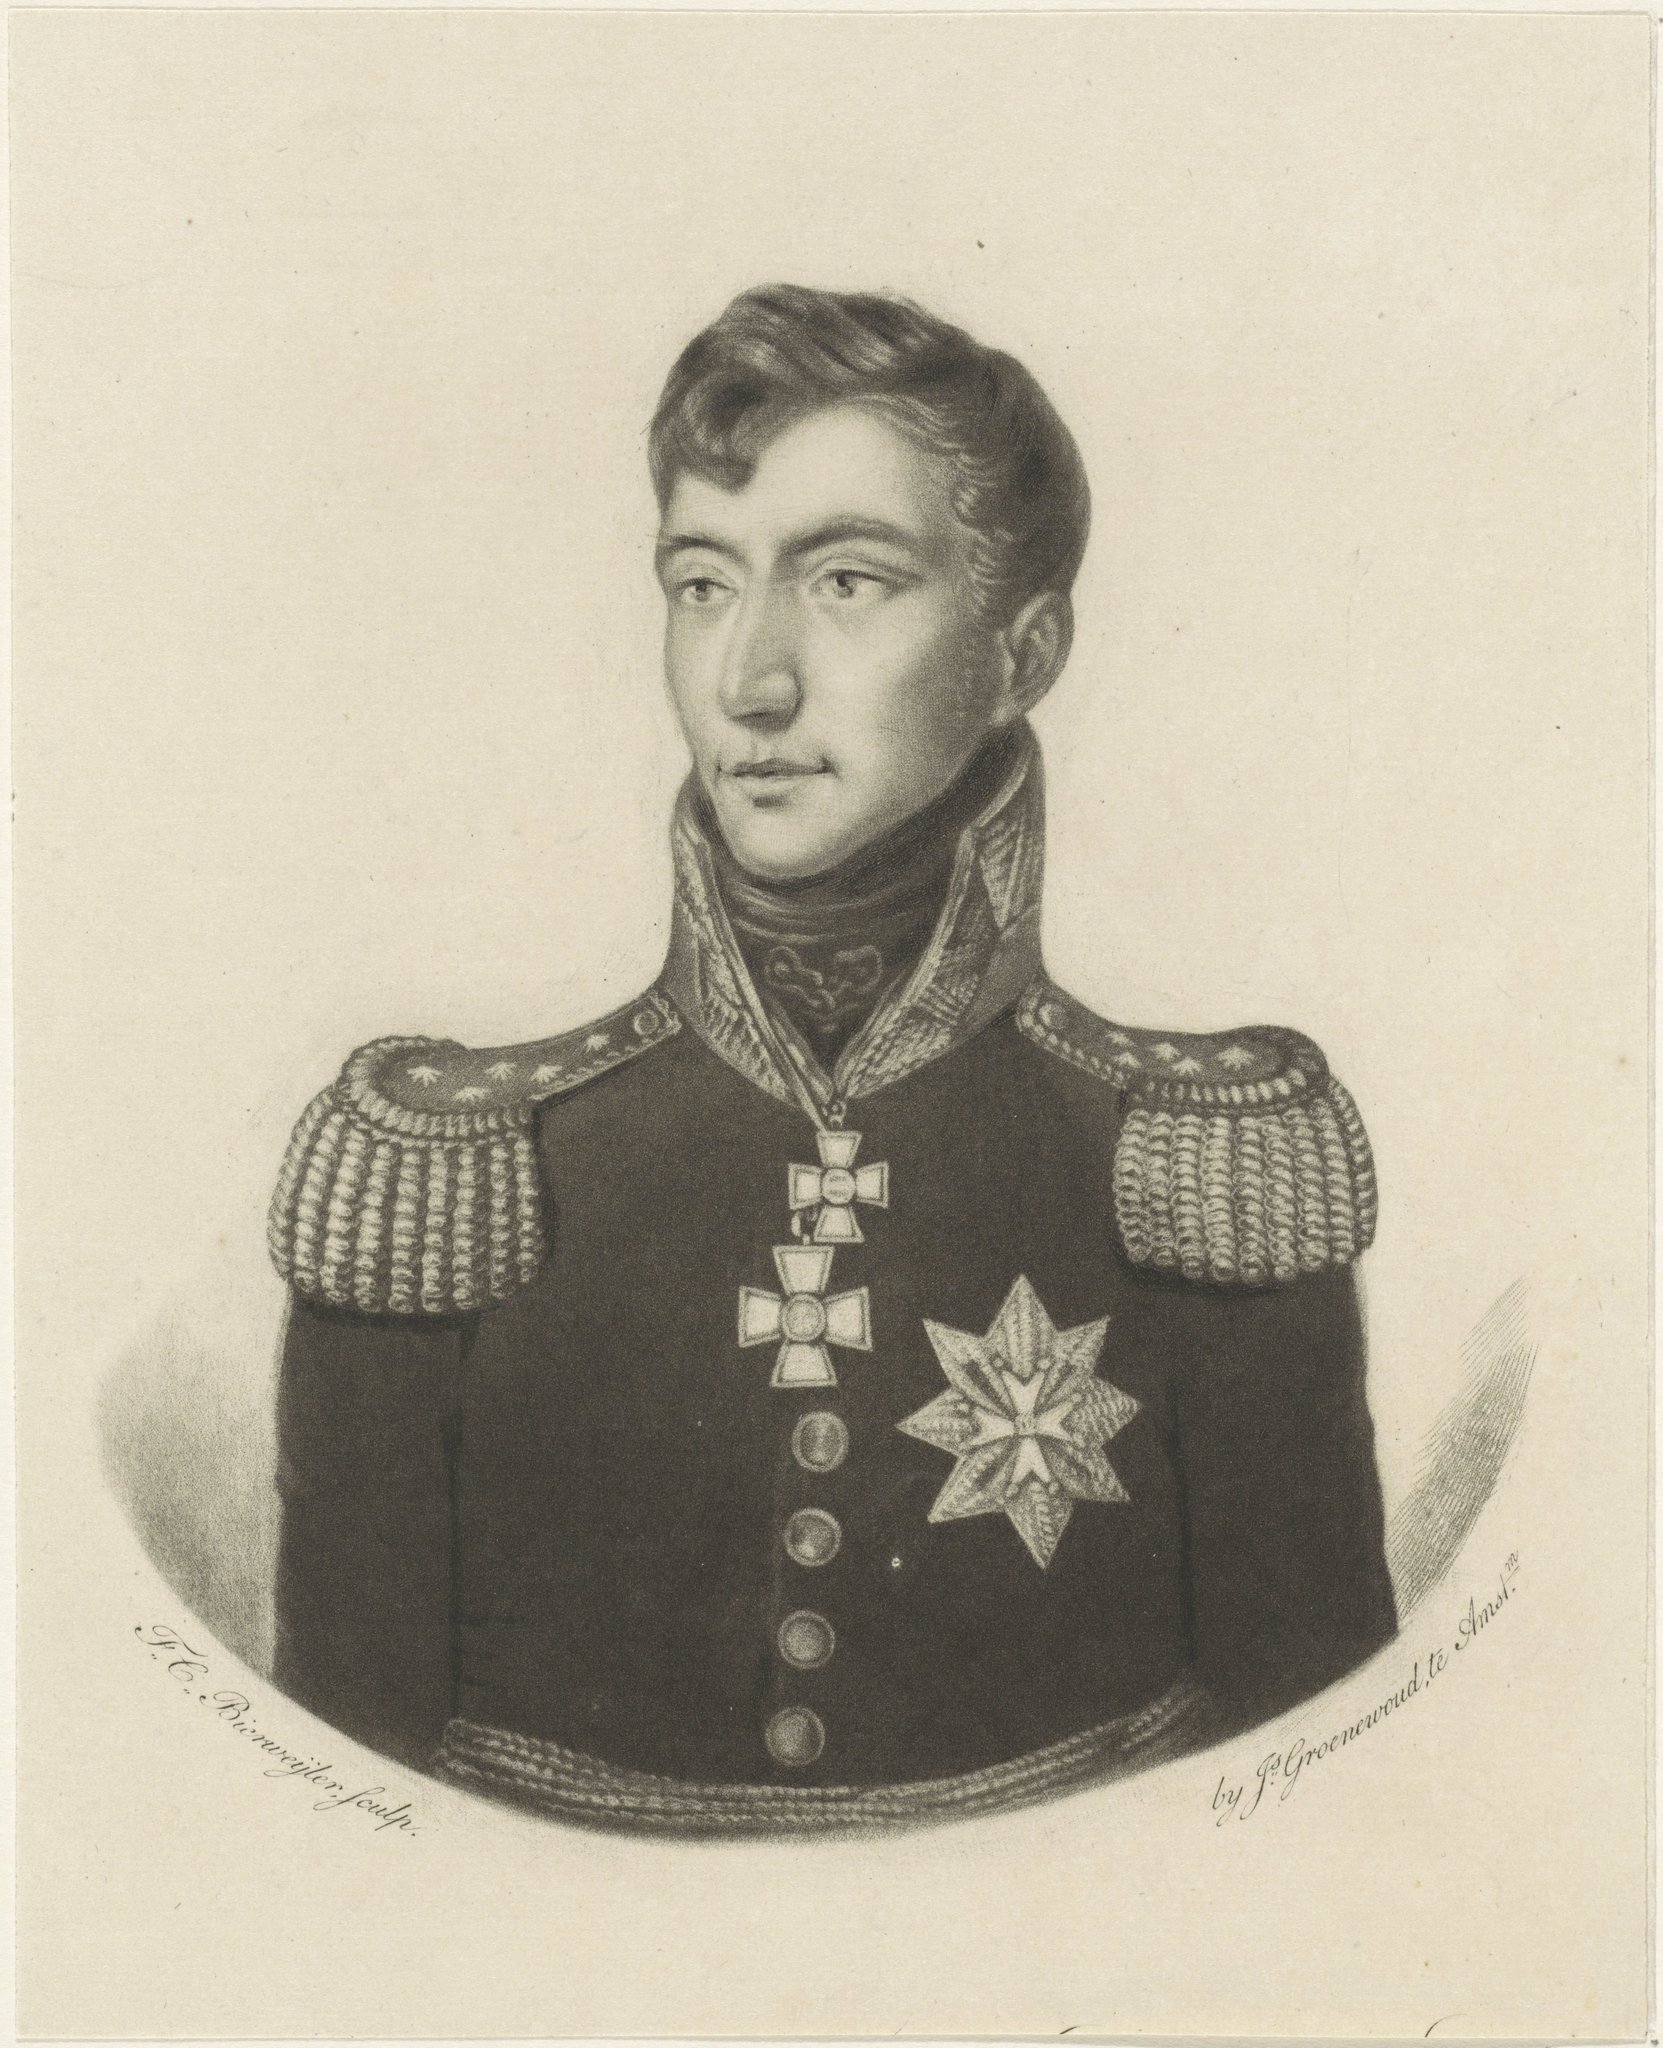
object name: print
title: Portret van Willem II, koning der Nederlanden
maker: j. groenewoud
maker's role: publisher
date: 1810-1819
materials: paper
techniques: aquatint, etching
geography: amsterdam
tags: the hague, william ii of the netherlands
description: De hier vermelde titel verwijst naar de hoogst verkregen titel van de geportretteerde, niet per se naar de titel die de geportretteerde op deze voorstelling draagt.